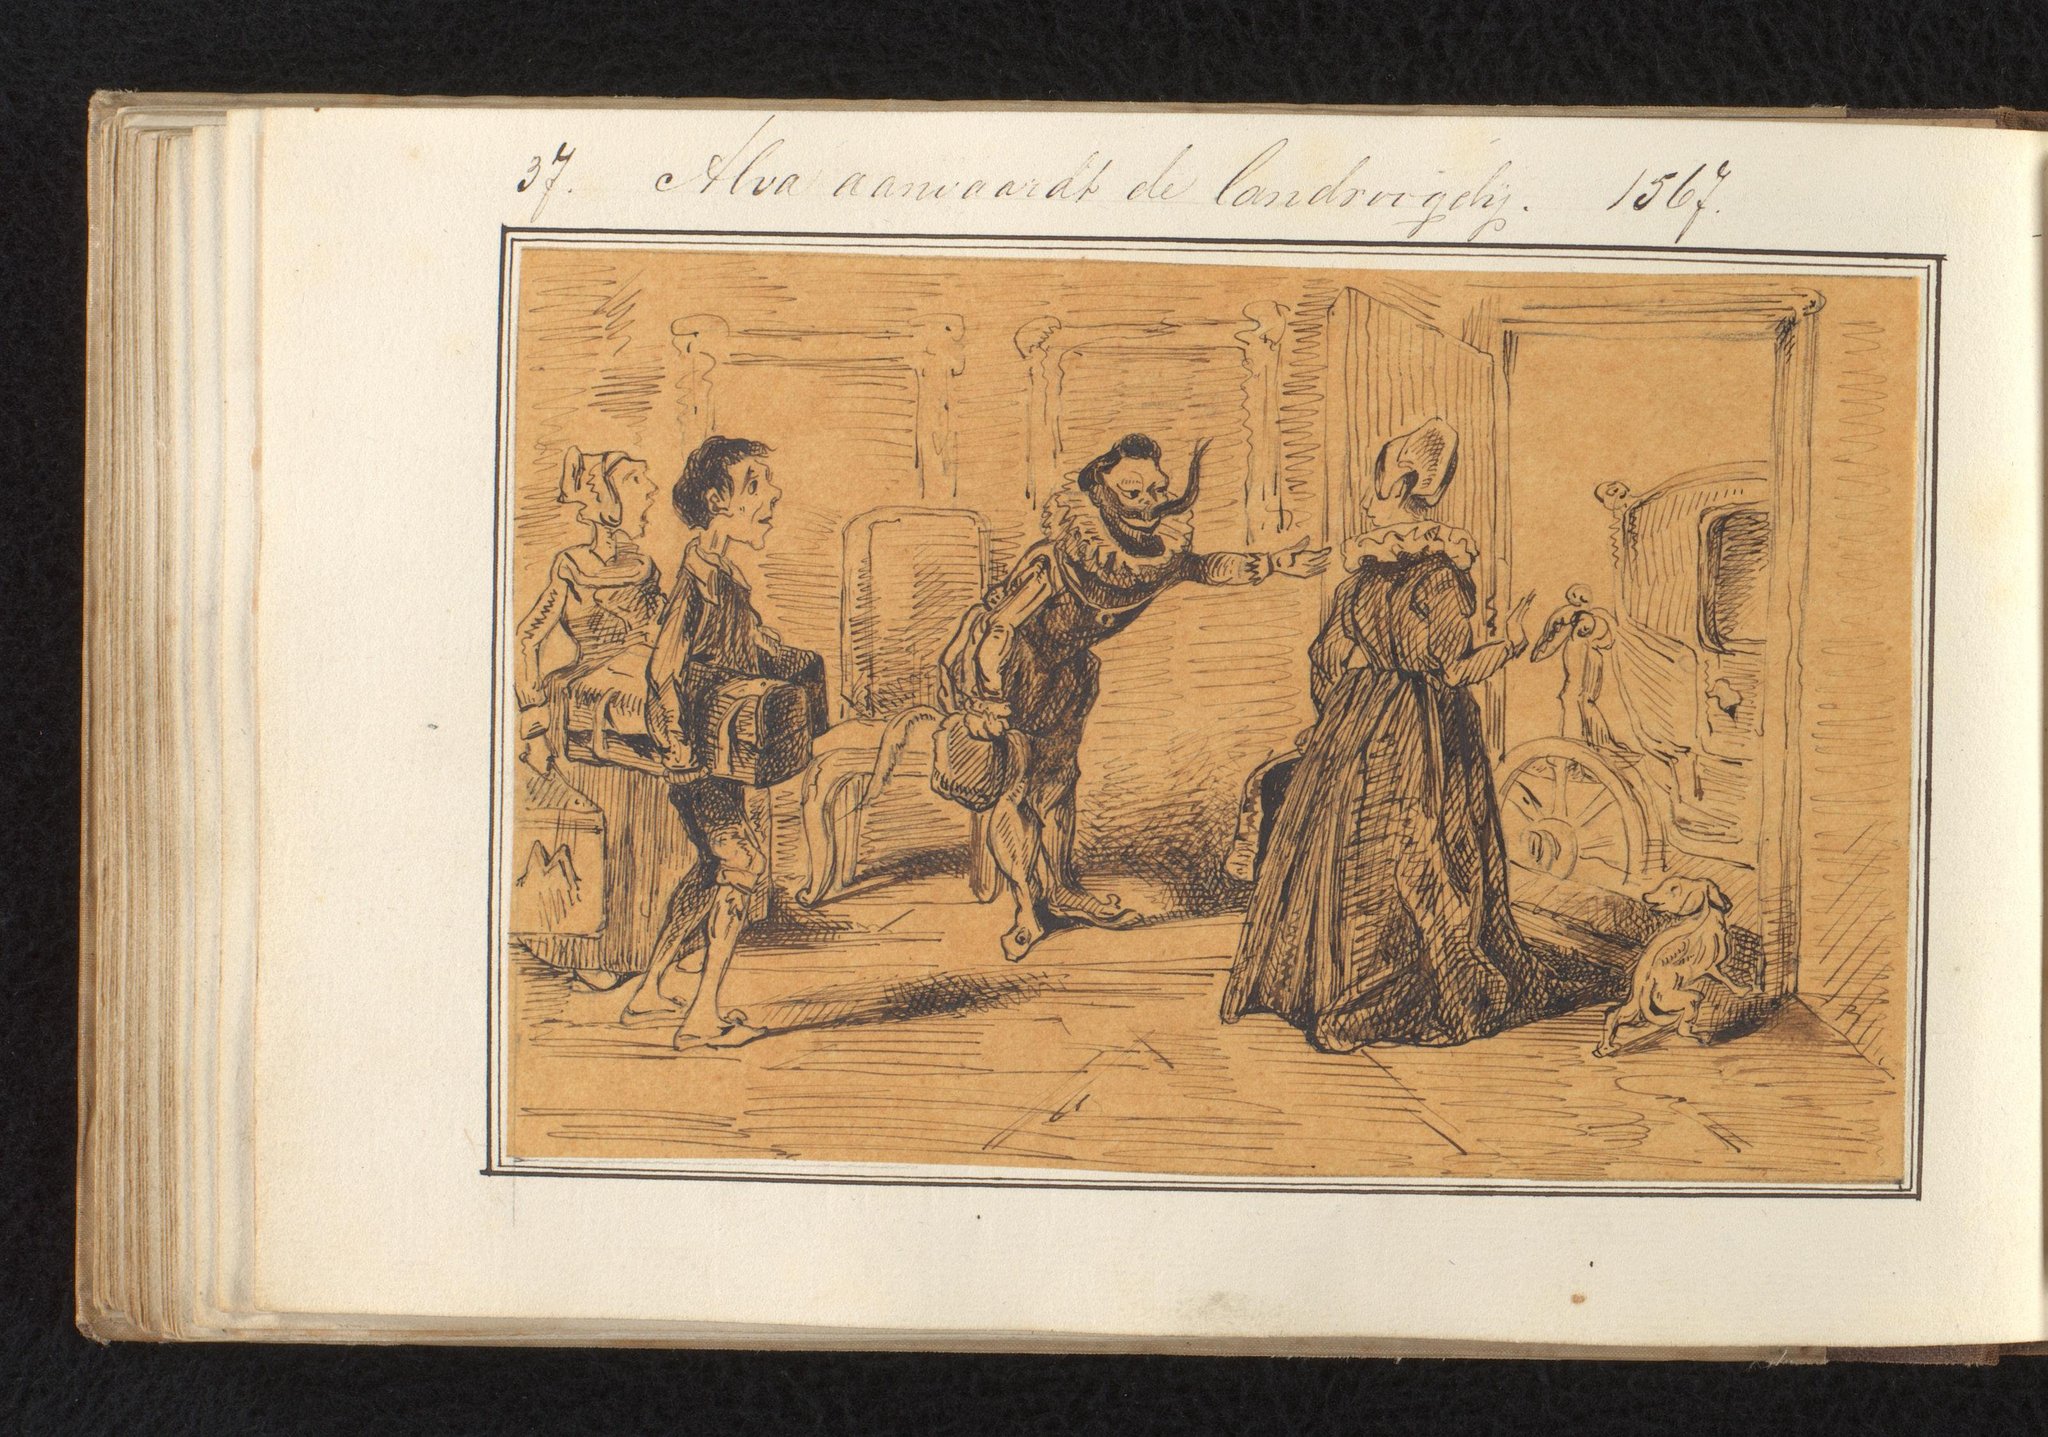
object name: boekillustratie ontwerp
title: Hertog van Alva wijst Margaretha van Parma de deur, 1567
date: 1853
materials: ink, pencil, paper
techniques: pen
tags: fernando álvarez de toledo (3rd duke of alba), animal traction, animal-drawn vehicle (carriage etc.), ruler, sovereign - bb - female ruler, departure ~ travelling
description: In 1567 trad Margaretha van Parma af als landvoogdes van de Nederlanden. Zij werd opgevolgd door de hertog van Alva. Tekening maakt deel uit van een manuscript.